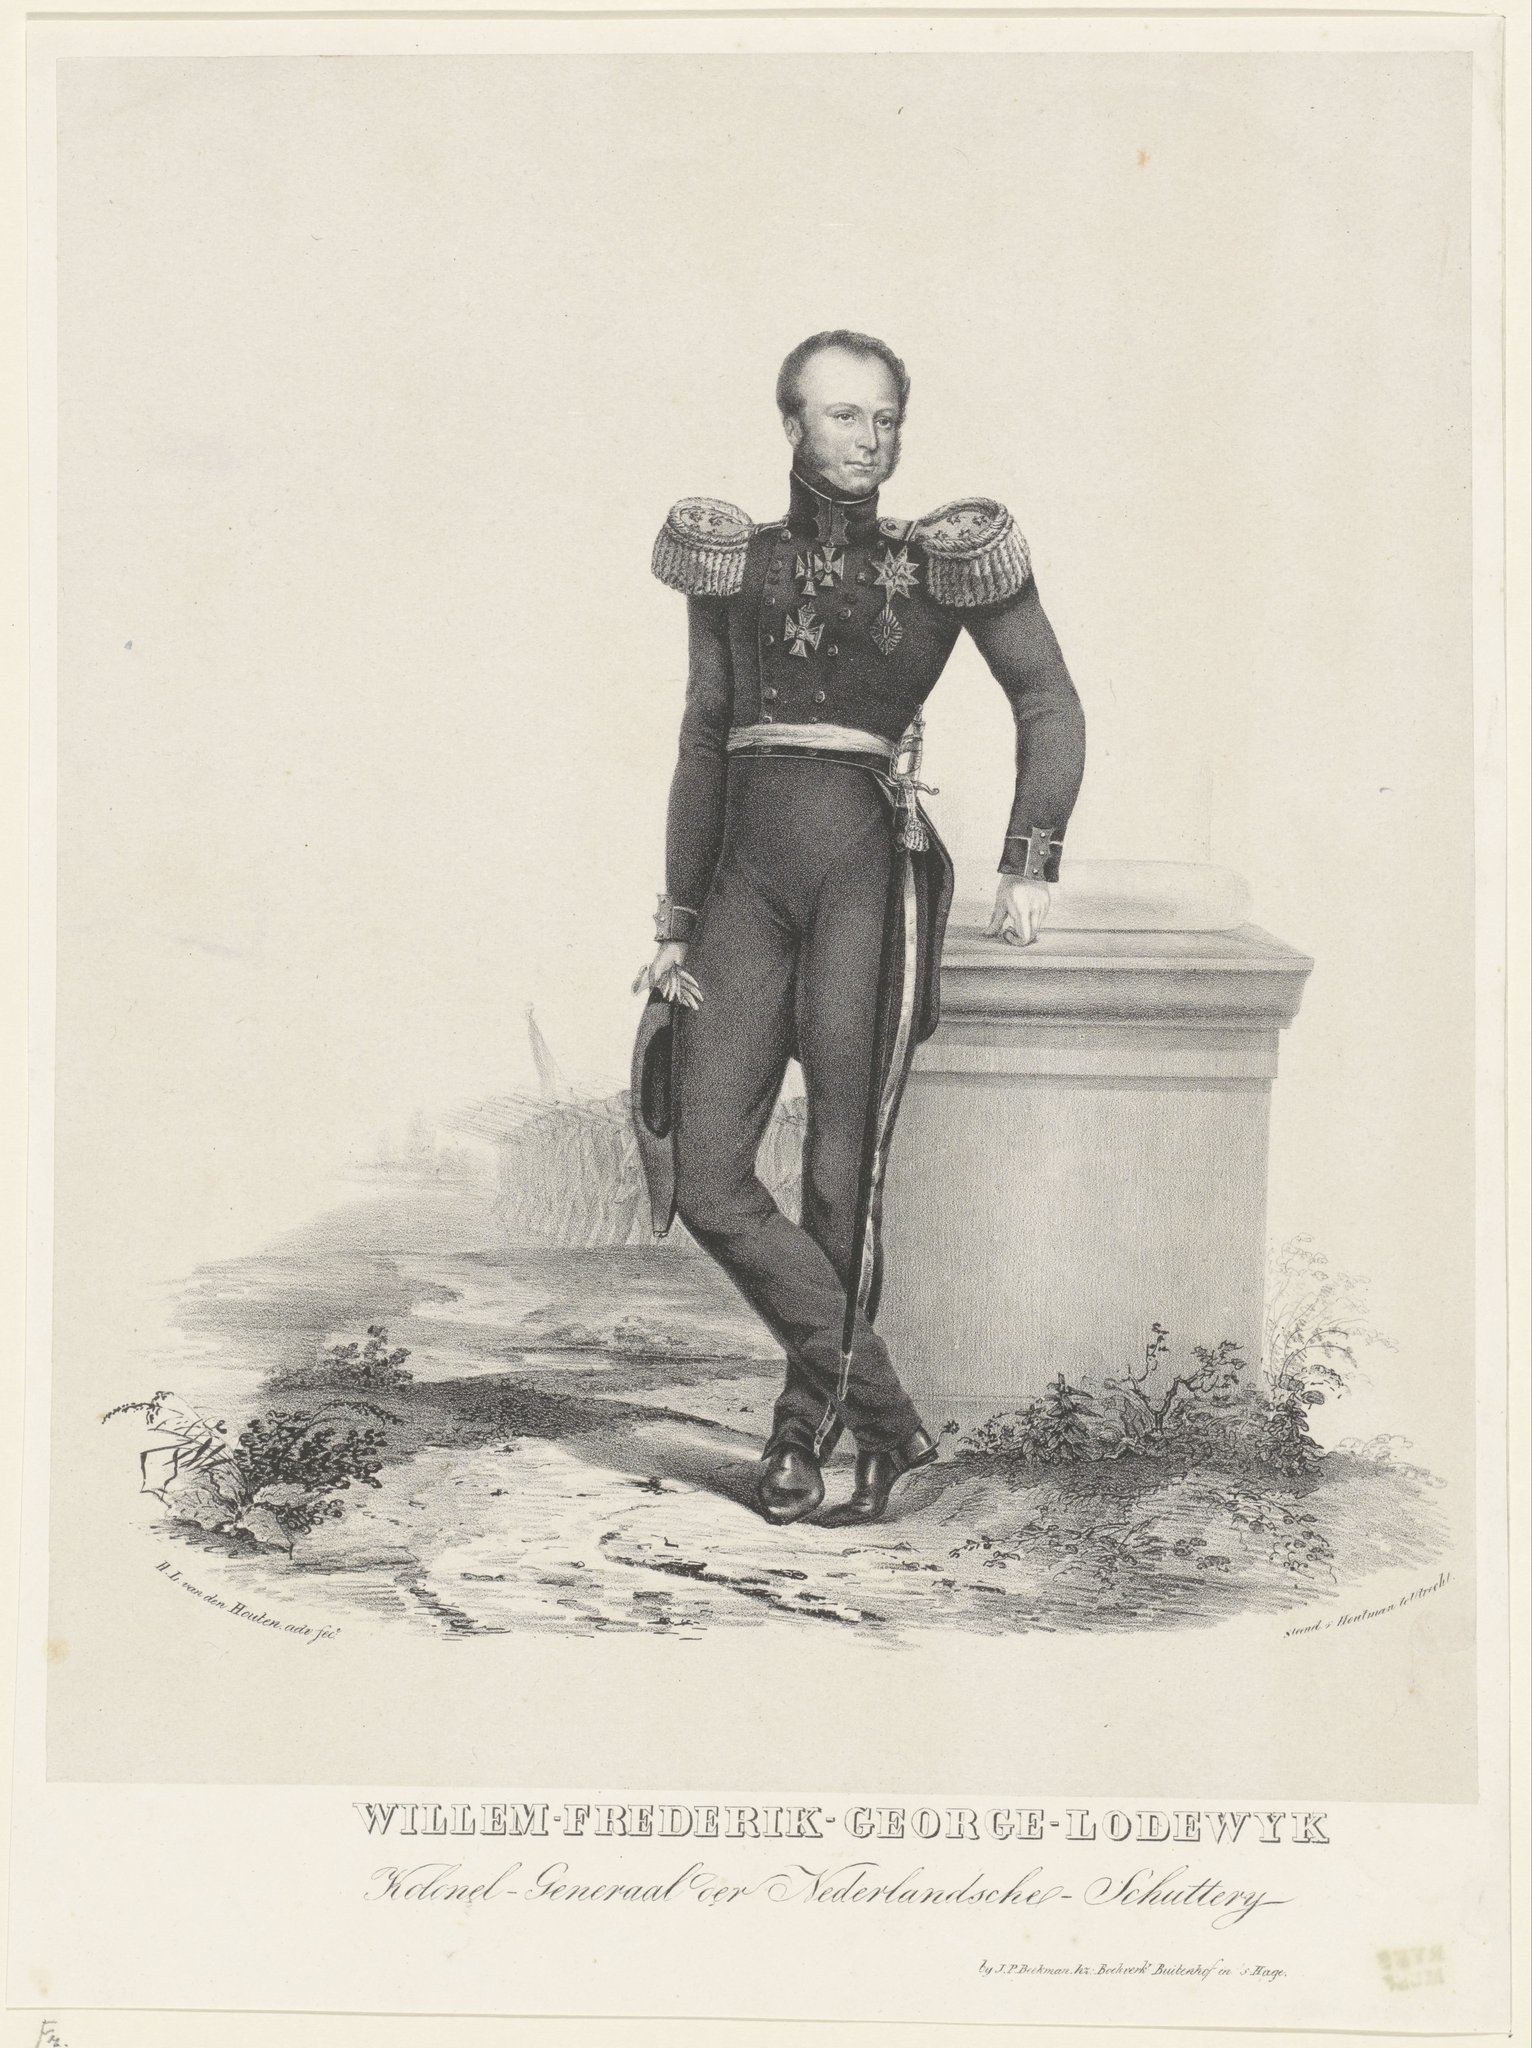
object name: print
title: Portret van Willem II, koning der Nederlanden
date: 1829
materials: paper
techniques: lithograph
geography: netherlands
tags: the hague, william ii of the netherlands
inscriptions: collector's mark: Lugt 2165, collector's mark: Lugt 963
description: De hier vermelde titel verwijst naar de hoogst verkregen titel van de geportretteerde, niet per se naar de titel die de geportretteerde op deze voorstelling draagt.